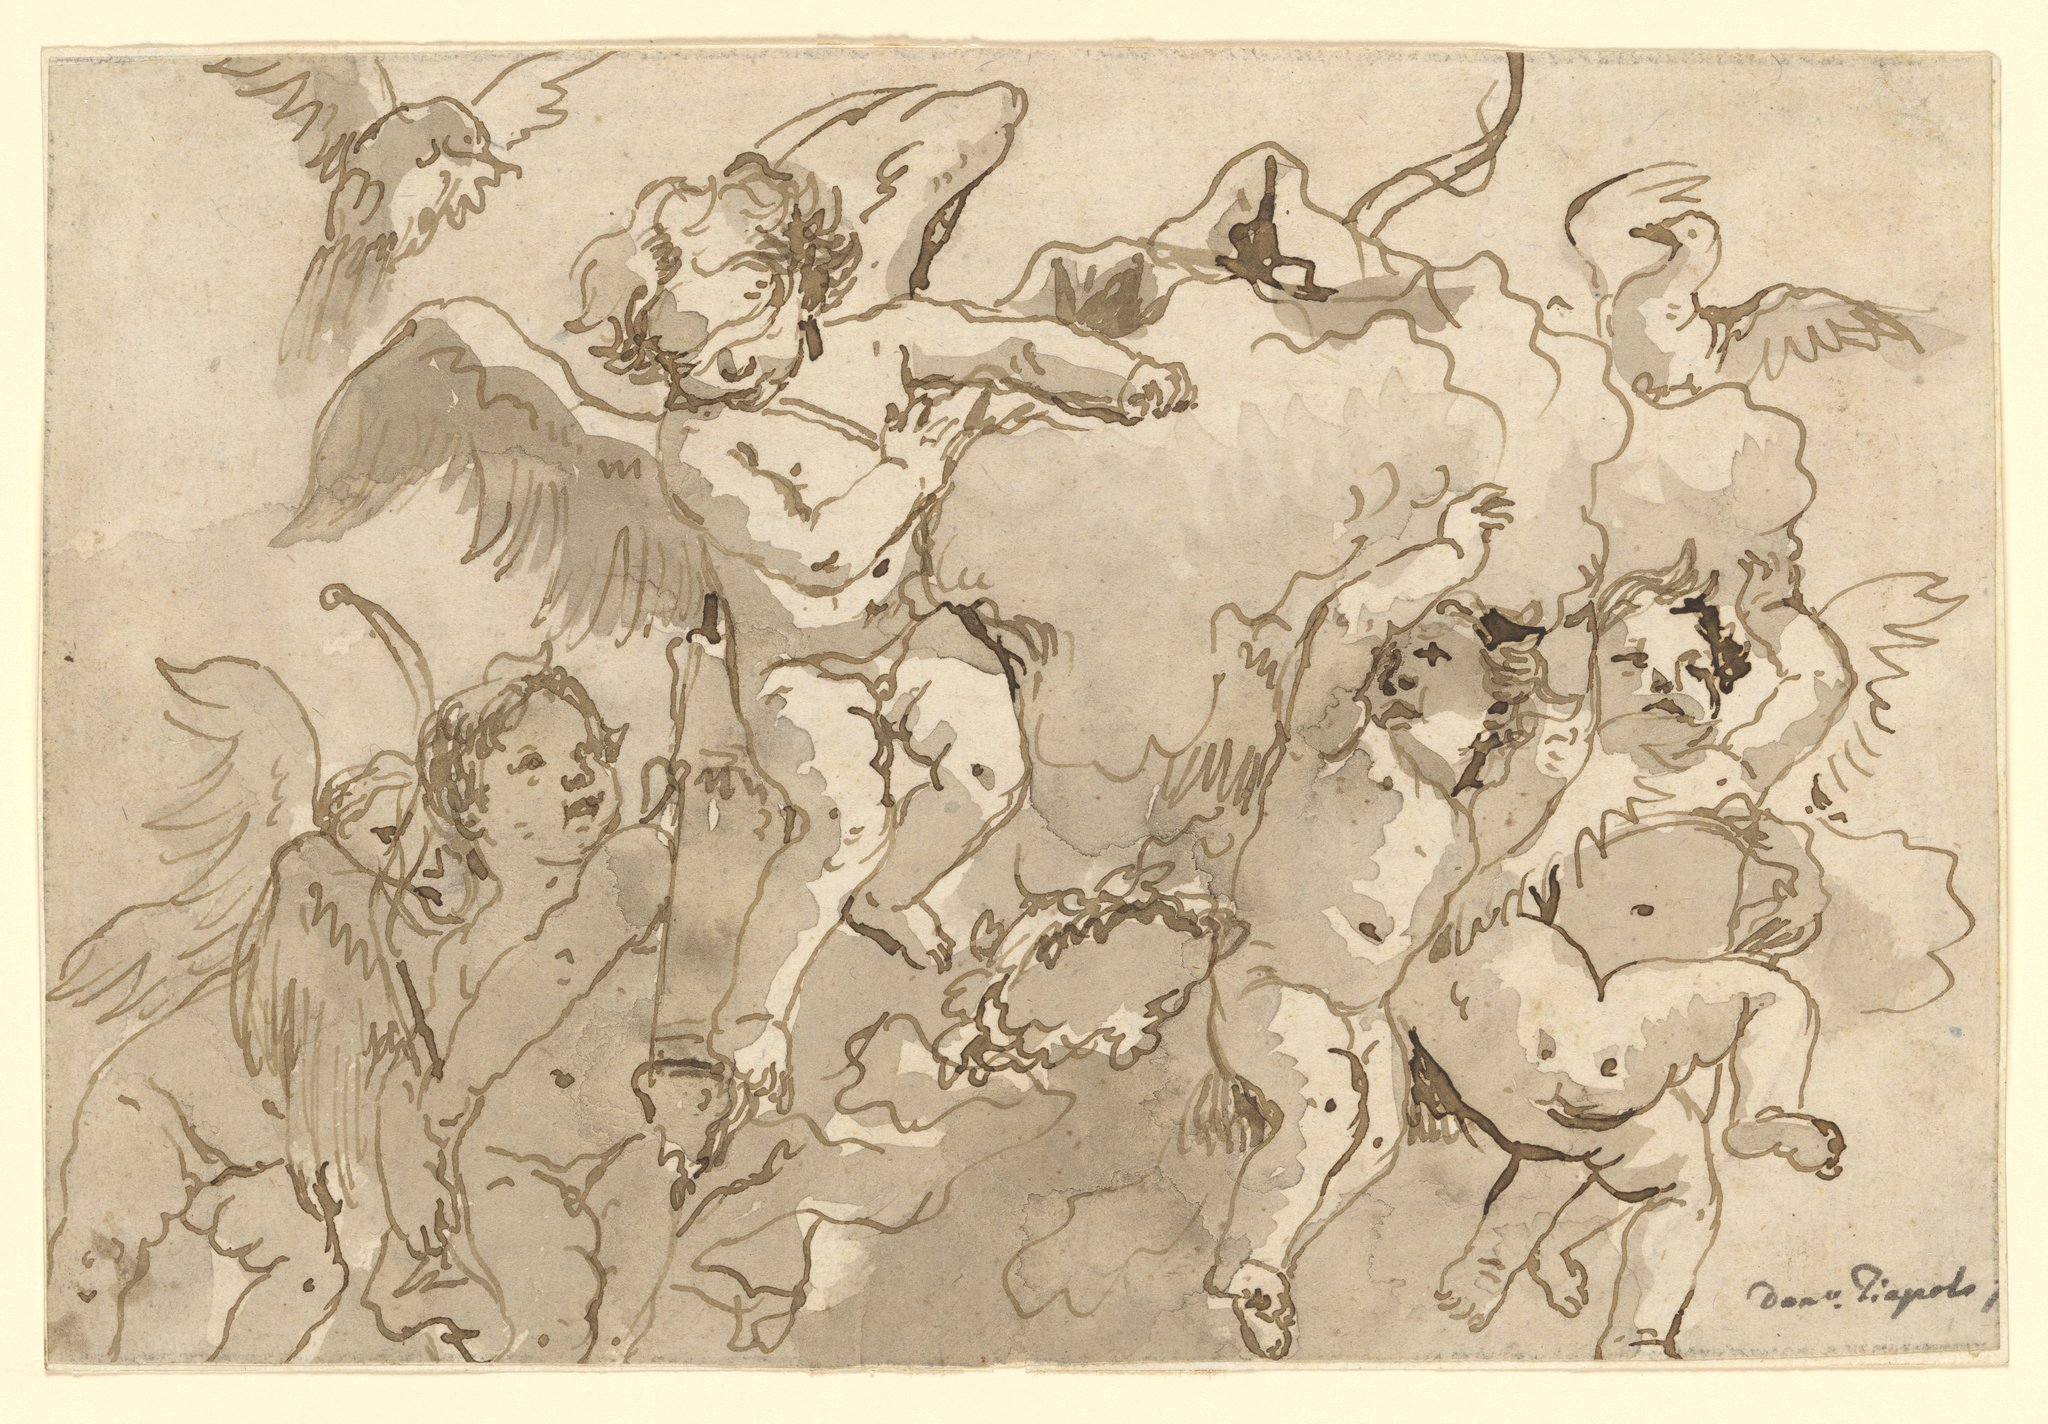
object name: drawing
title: Cupid Blindfolded in the Clouds, with Five Attendant Putti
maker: giovanni domenico tiepolo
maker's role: artist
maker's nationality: italian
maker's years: 1727-1804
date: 1770-1790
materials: ink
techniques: pen, wash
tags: cupid,putti